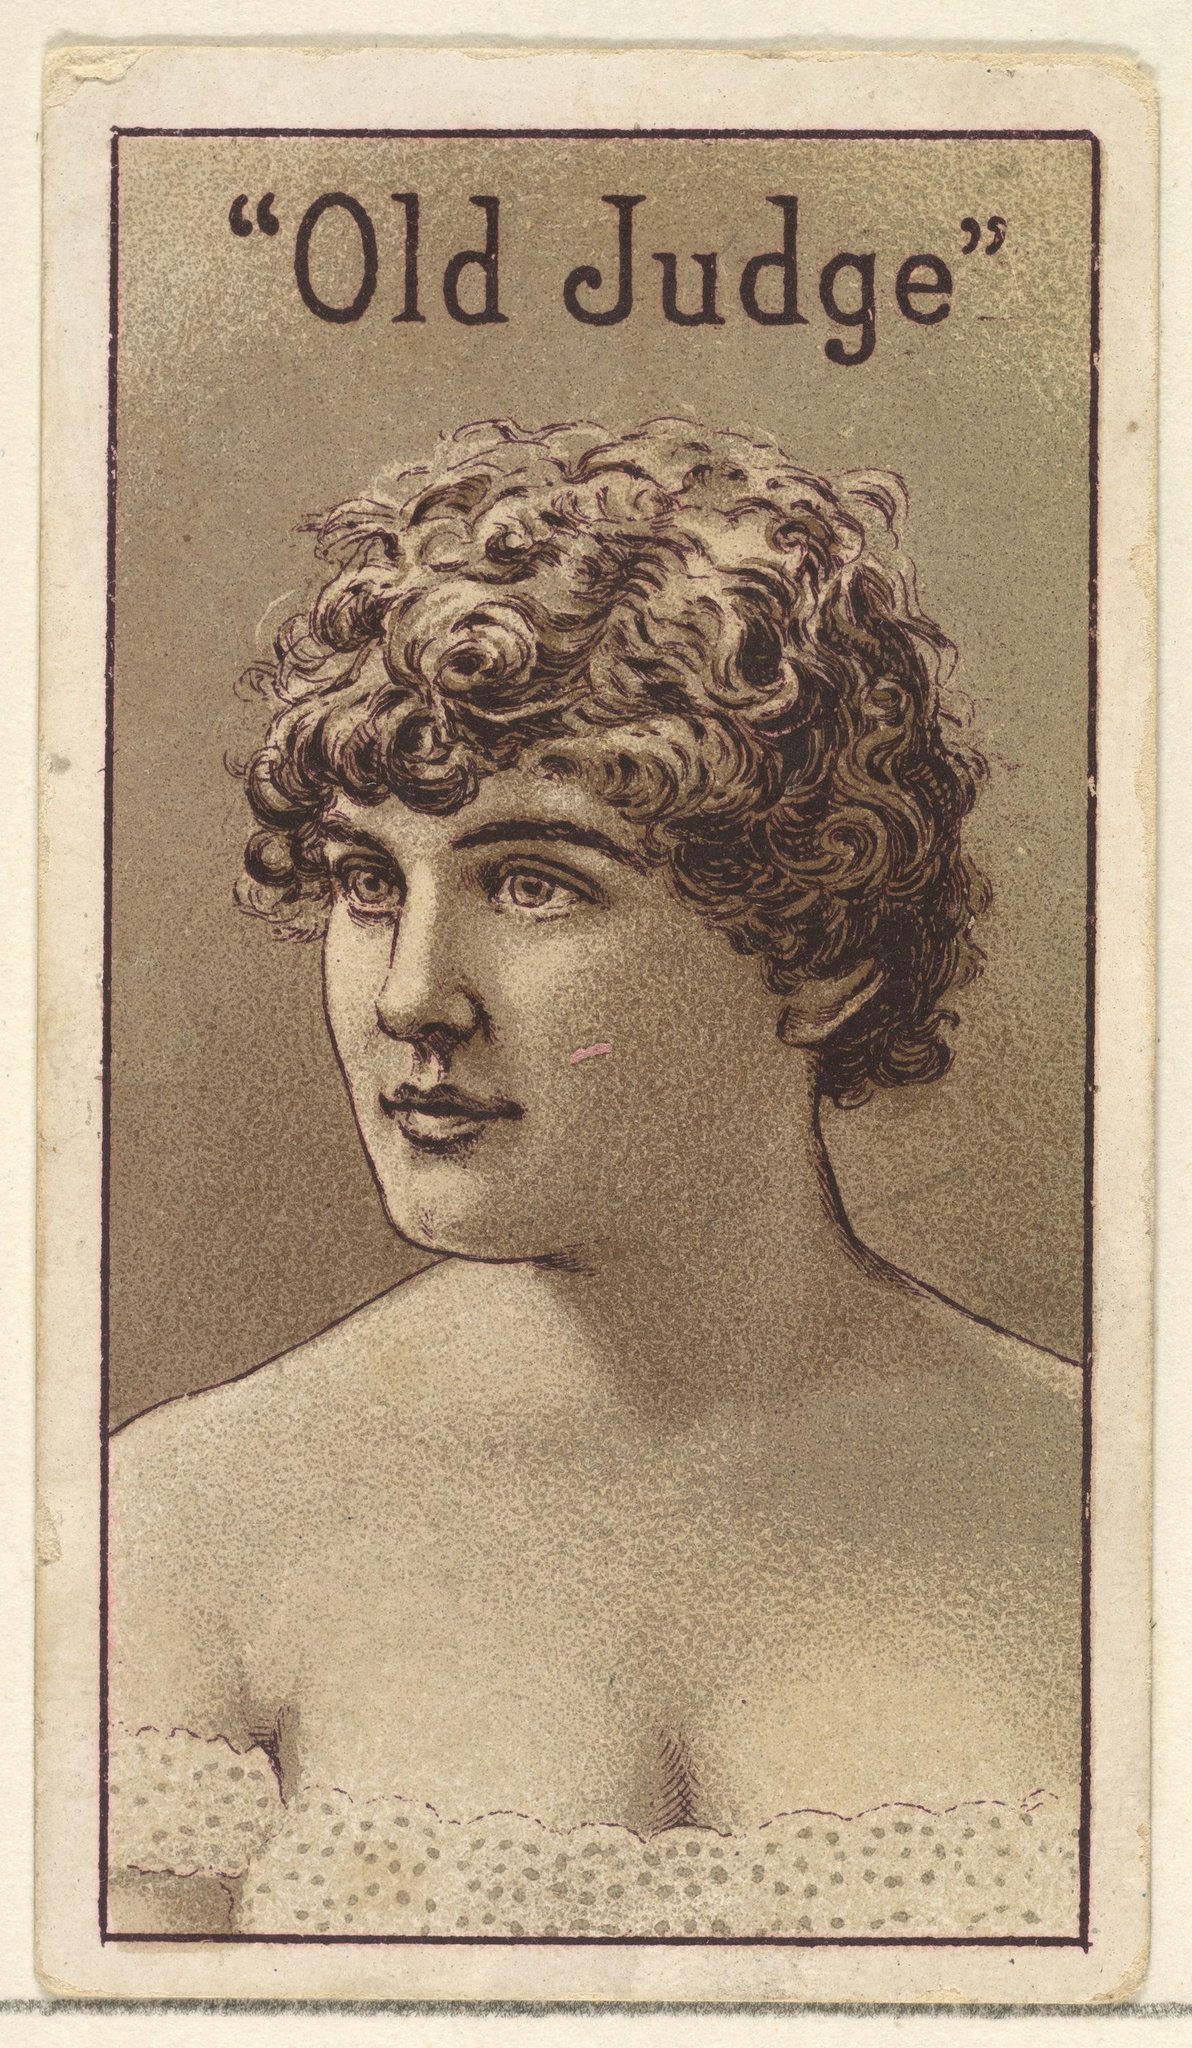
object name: print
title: Actress from the Old Judge series (N167) for Old Judge Cigarettes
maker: goodwin & company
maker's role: publisher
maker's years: 1850-1950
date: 1886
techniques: lithography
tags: portraits,women